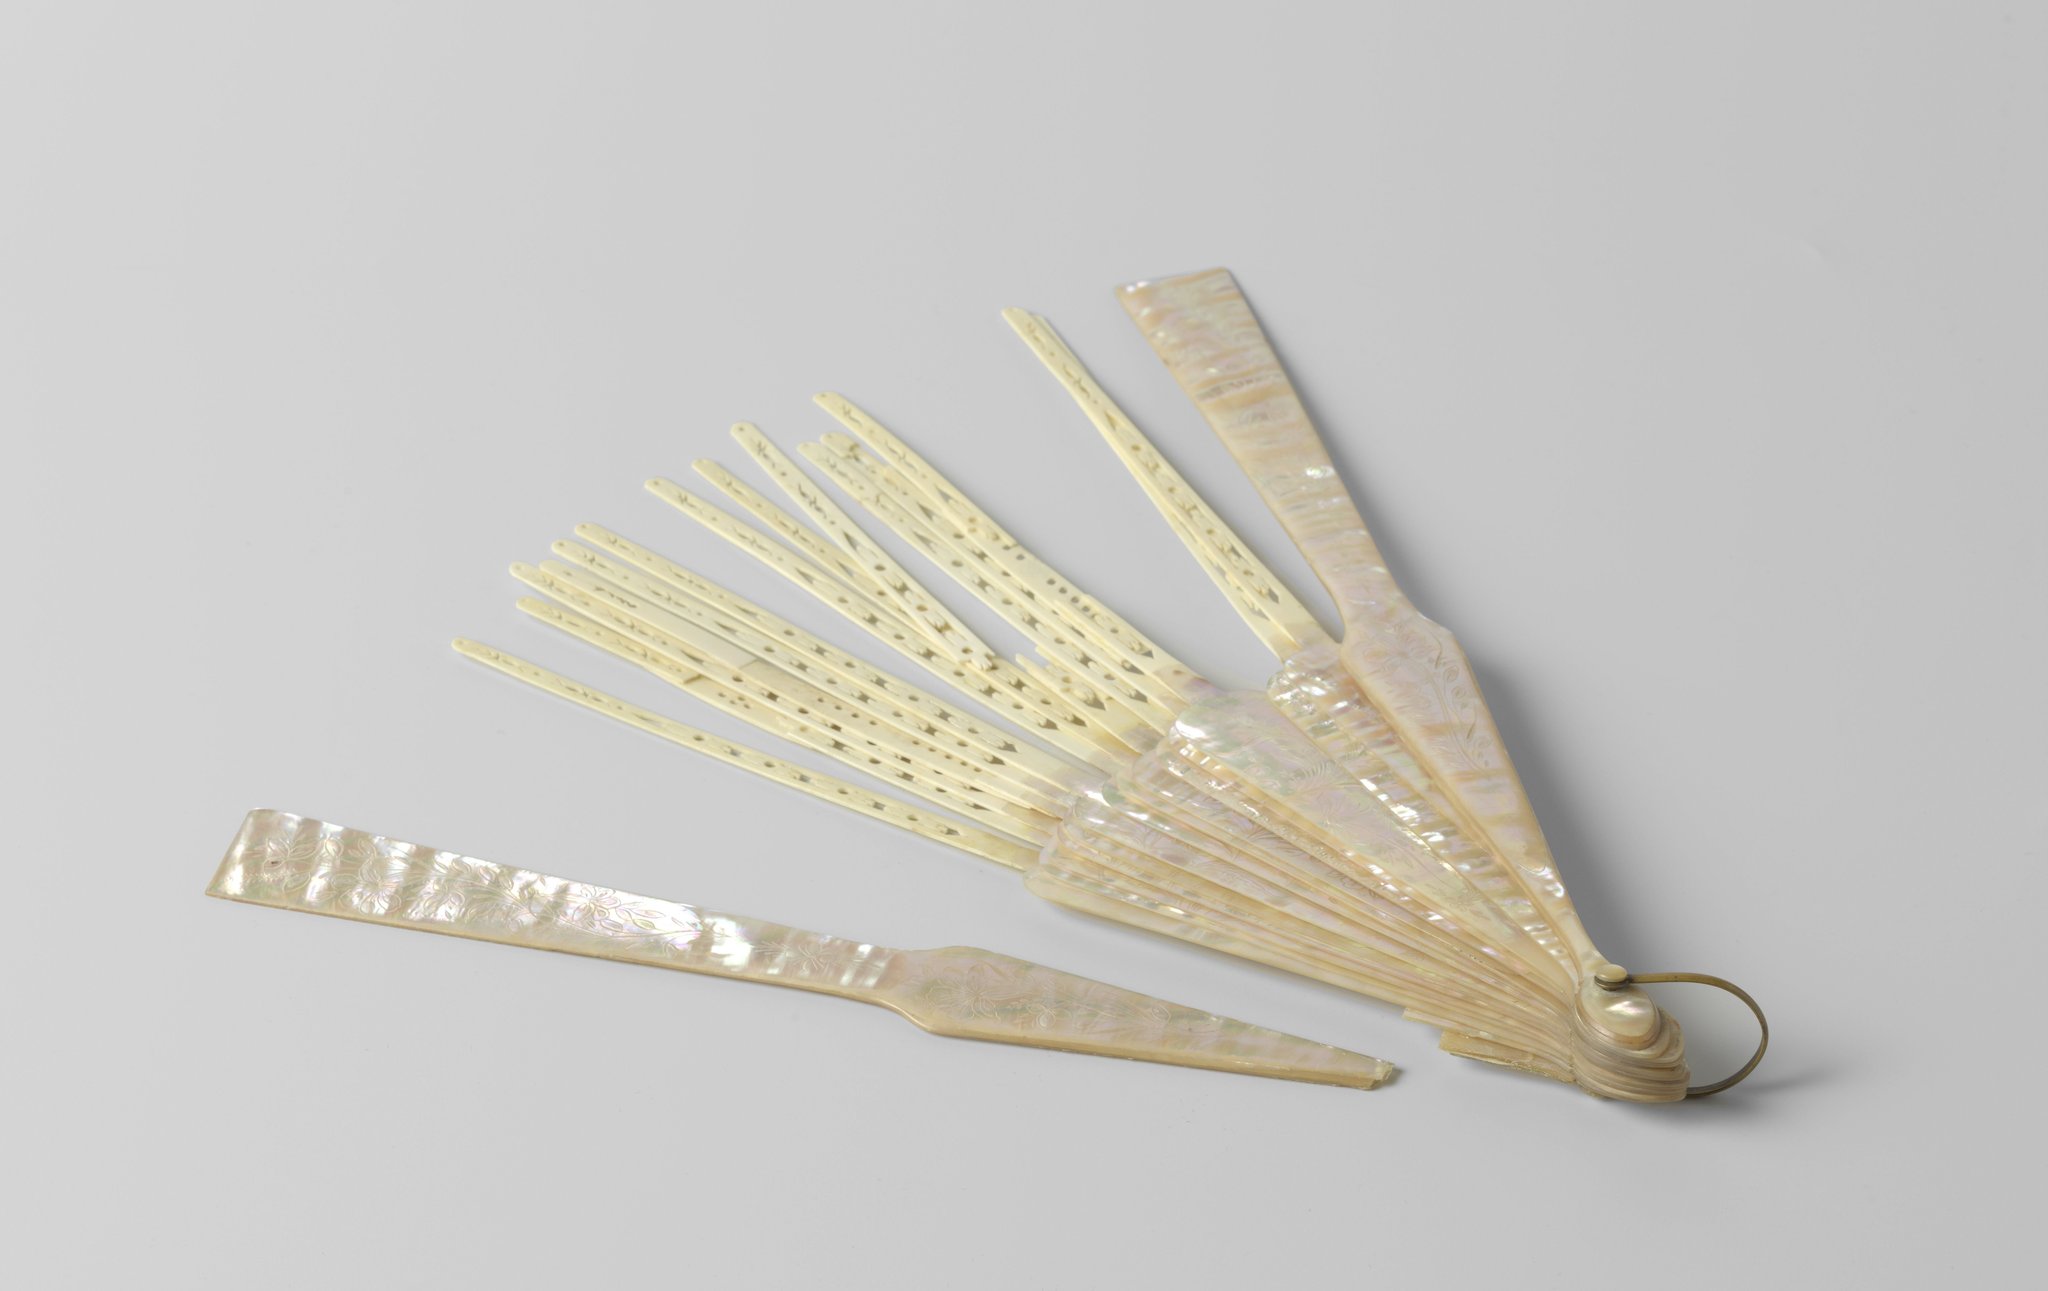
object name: setting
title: Montuur van parelmoer met in reliëf een bloemmotief en steundeel van opengewerkt been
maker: Anonymous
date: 1850-1900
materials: bone, copper, mother of pearl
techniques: cutting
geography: western europe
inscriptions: circumscription: ‘'Wiesje's cadeau voor eventuele restauratie van een kanten dekje'’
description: Montuur met handeel van parelmoer met in reliëf een bloemmotief en steundeel van opengewerkt been. Achterkant van het montuur is onbewerkt. Waaierring van koper.